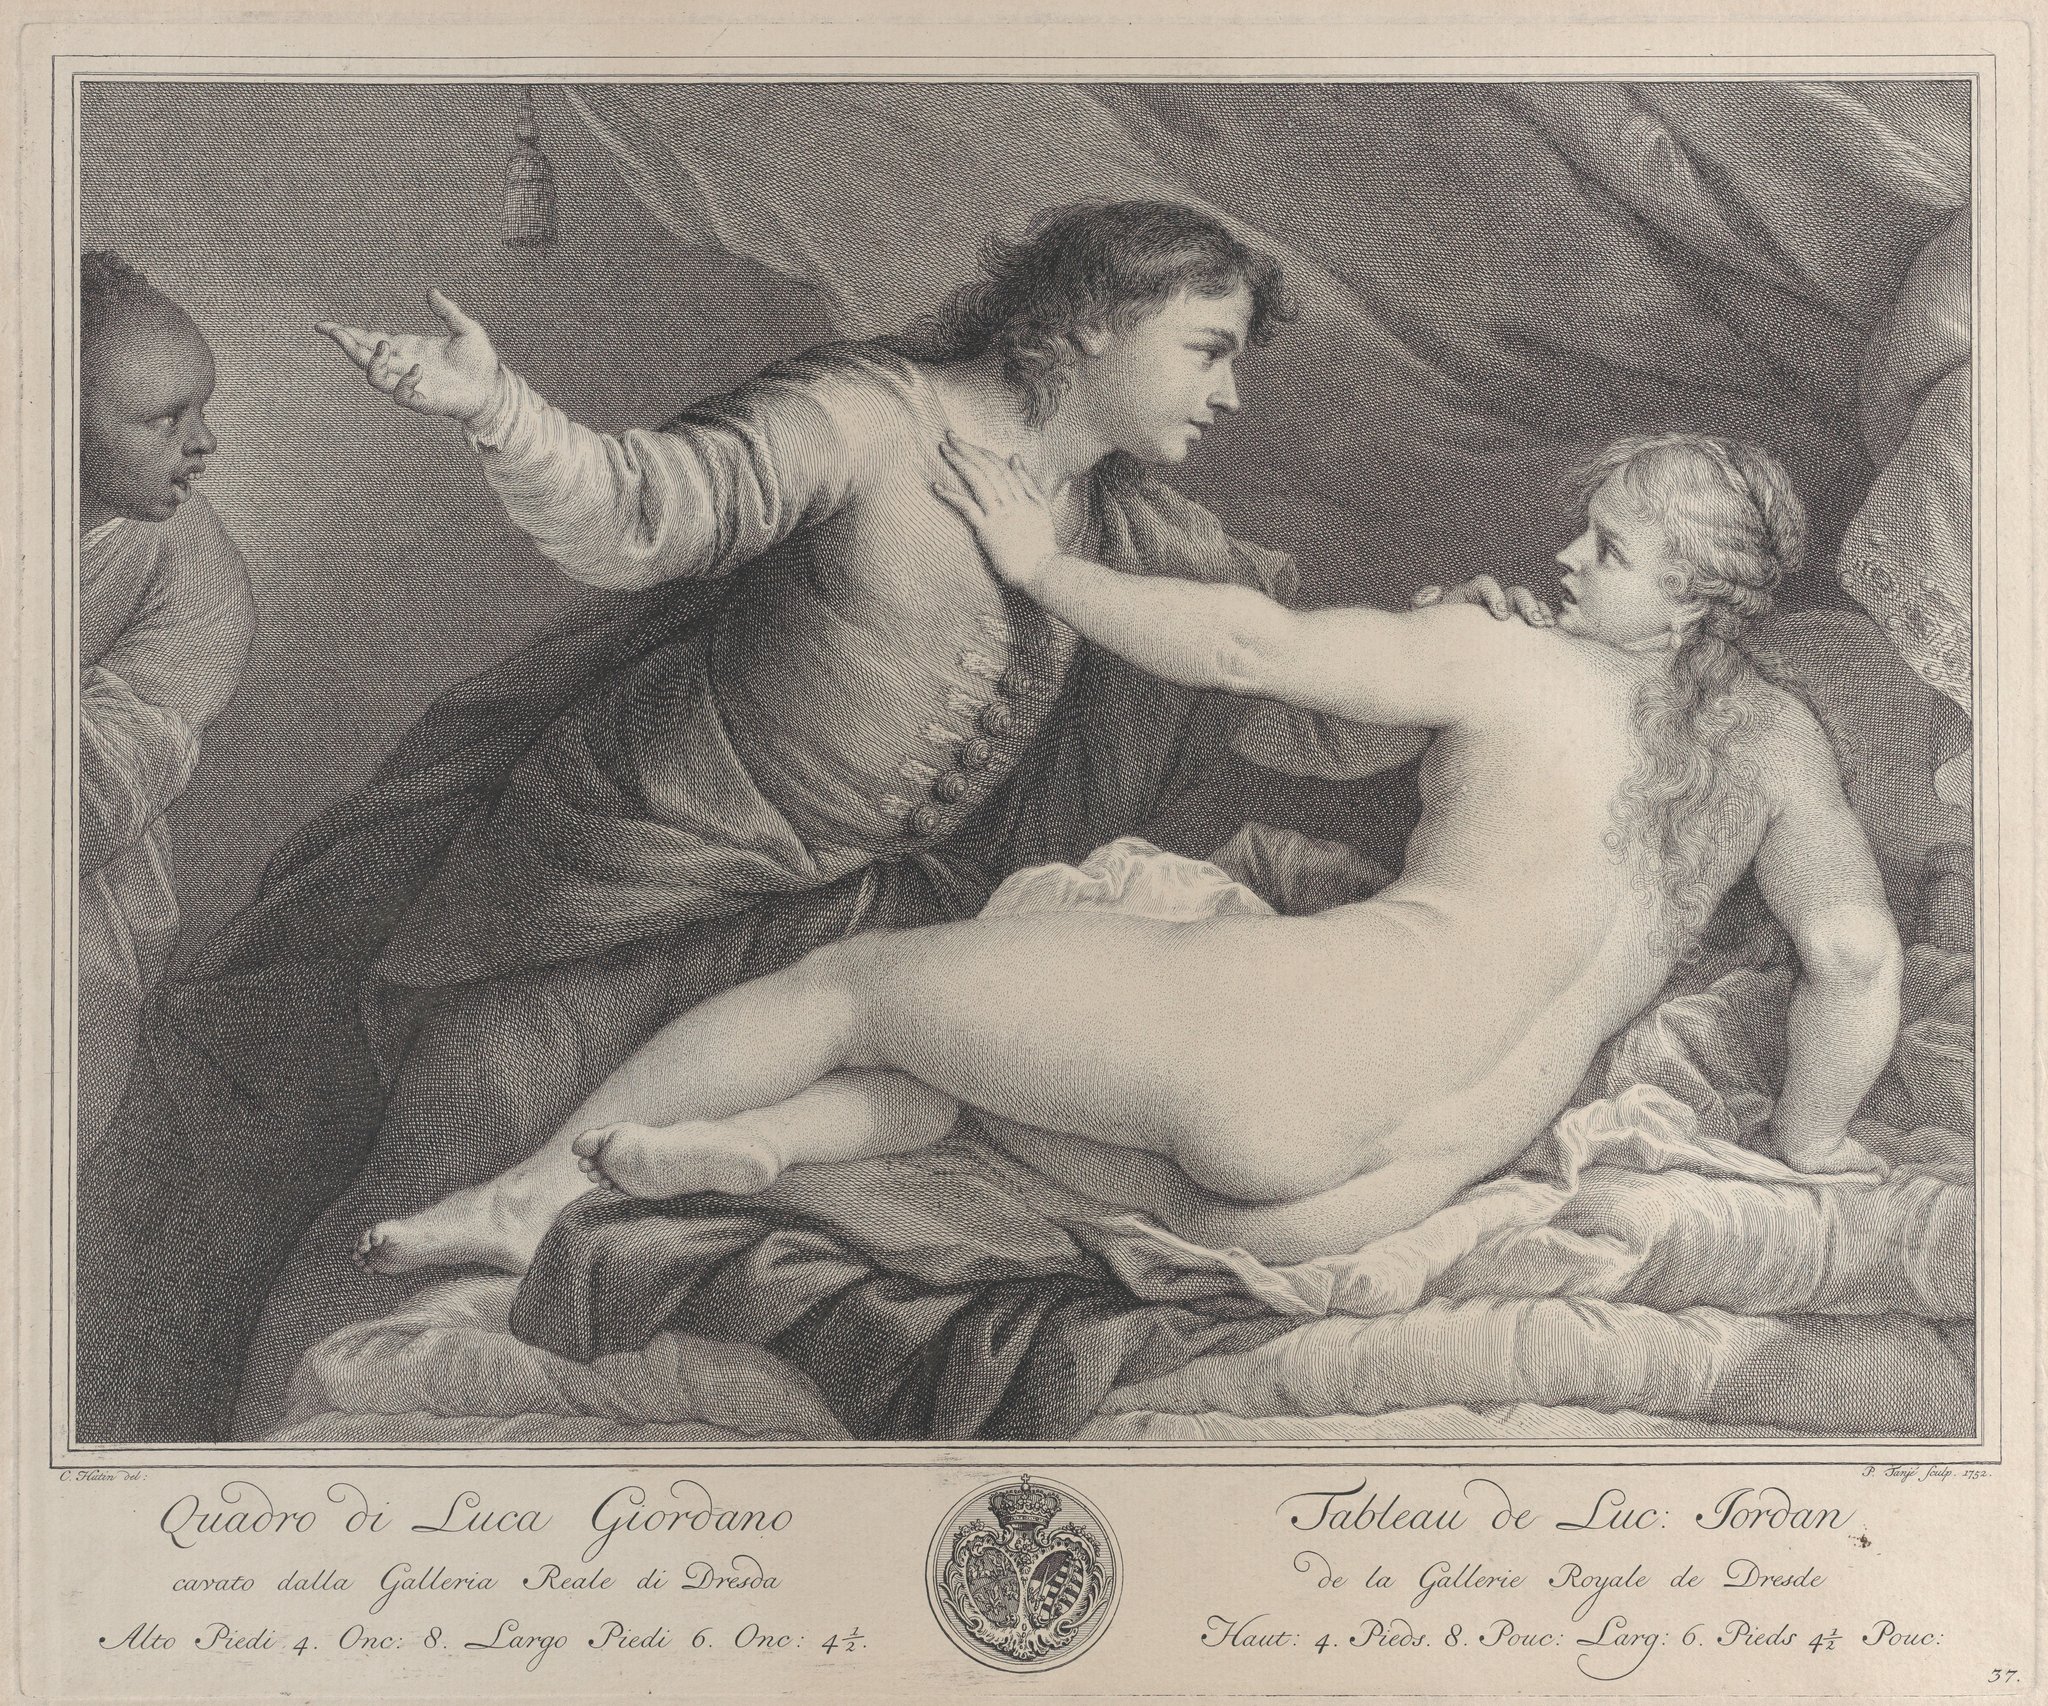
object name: print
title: Tarquin and Lucretia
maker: pieter tanjé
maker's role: artist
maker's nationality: dutch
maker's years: 1706-1761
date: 1752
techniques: engraving, etching